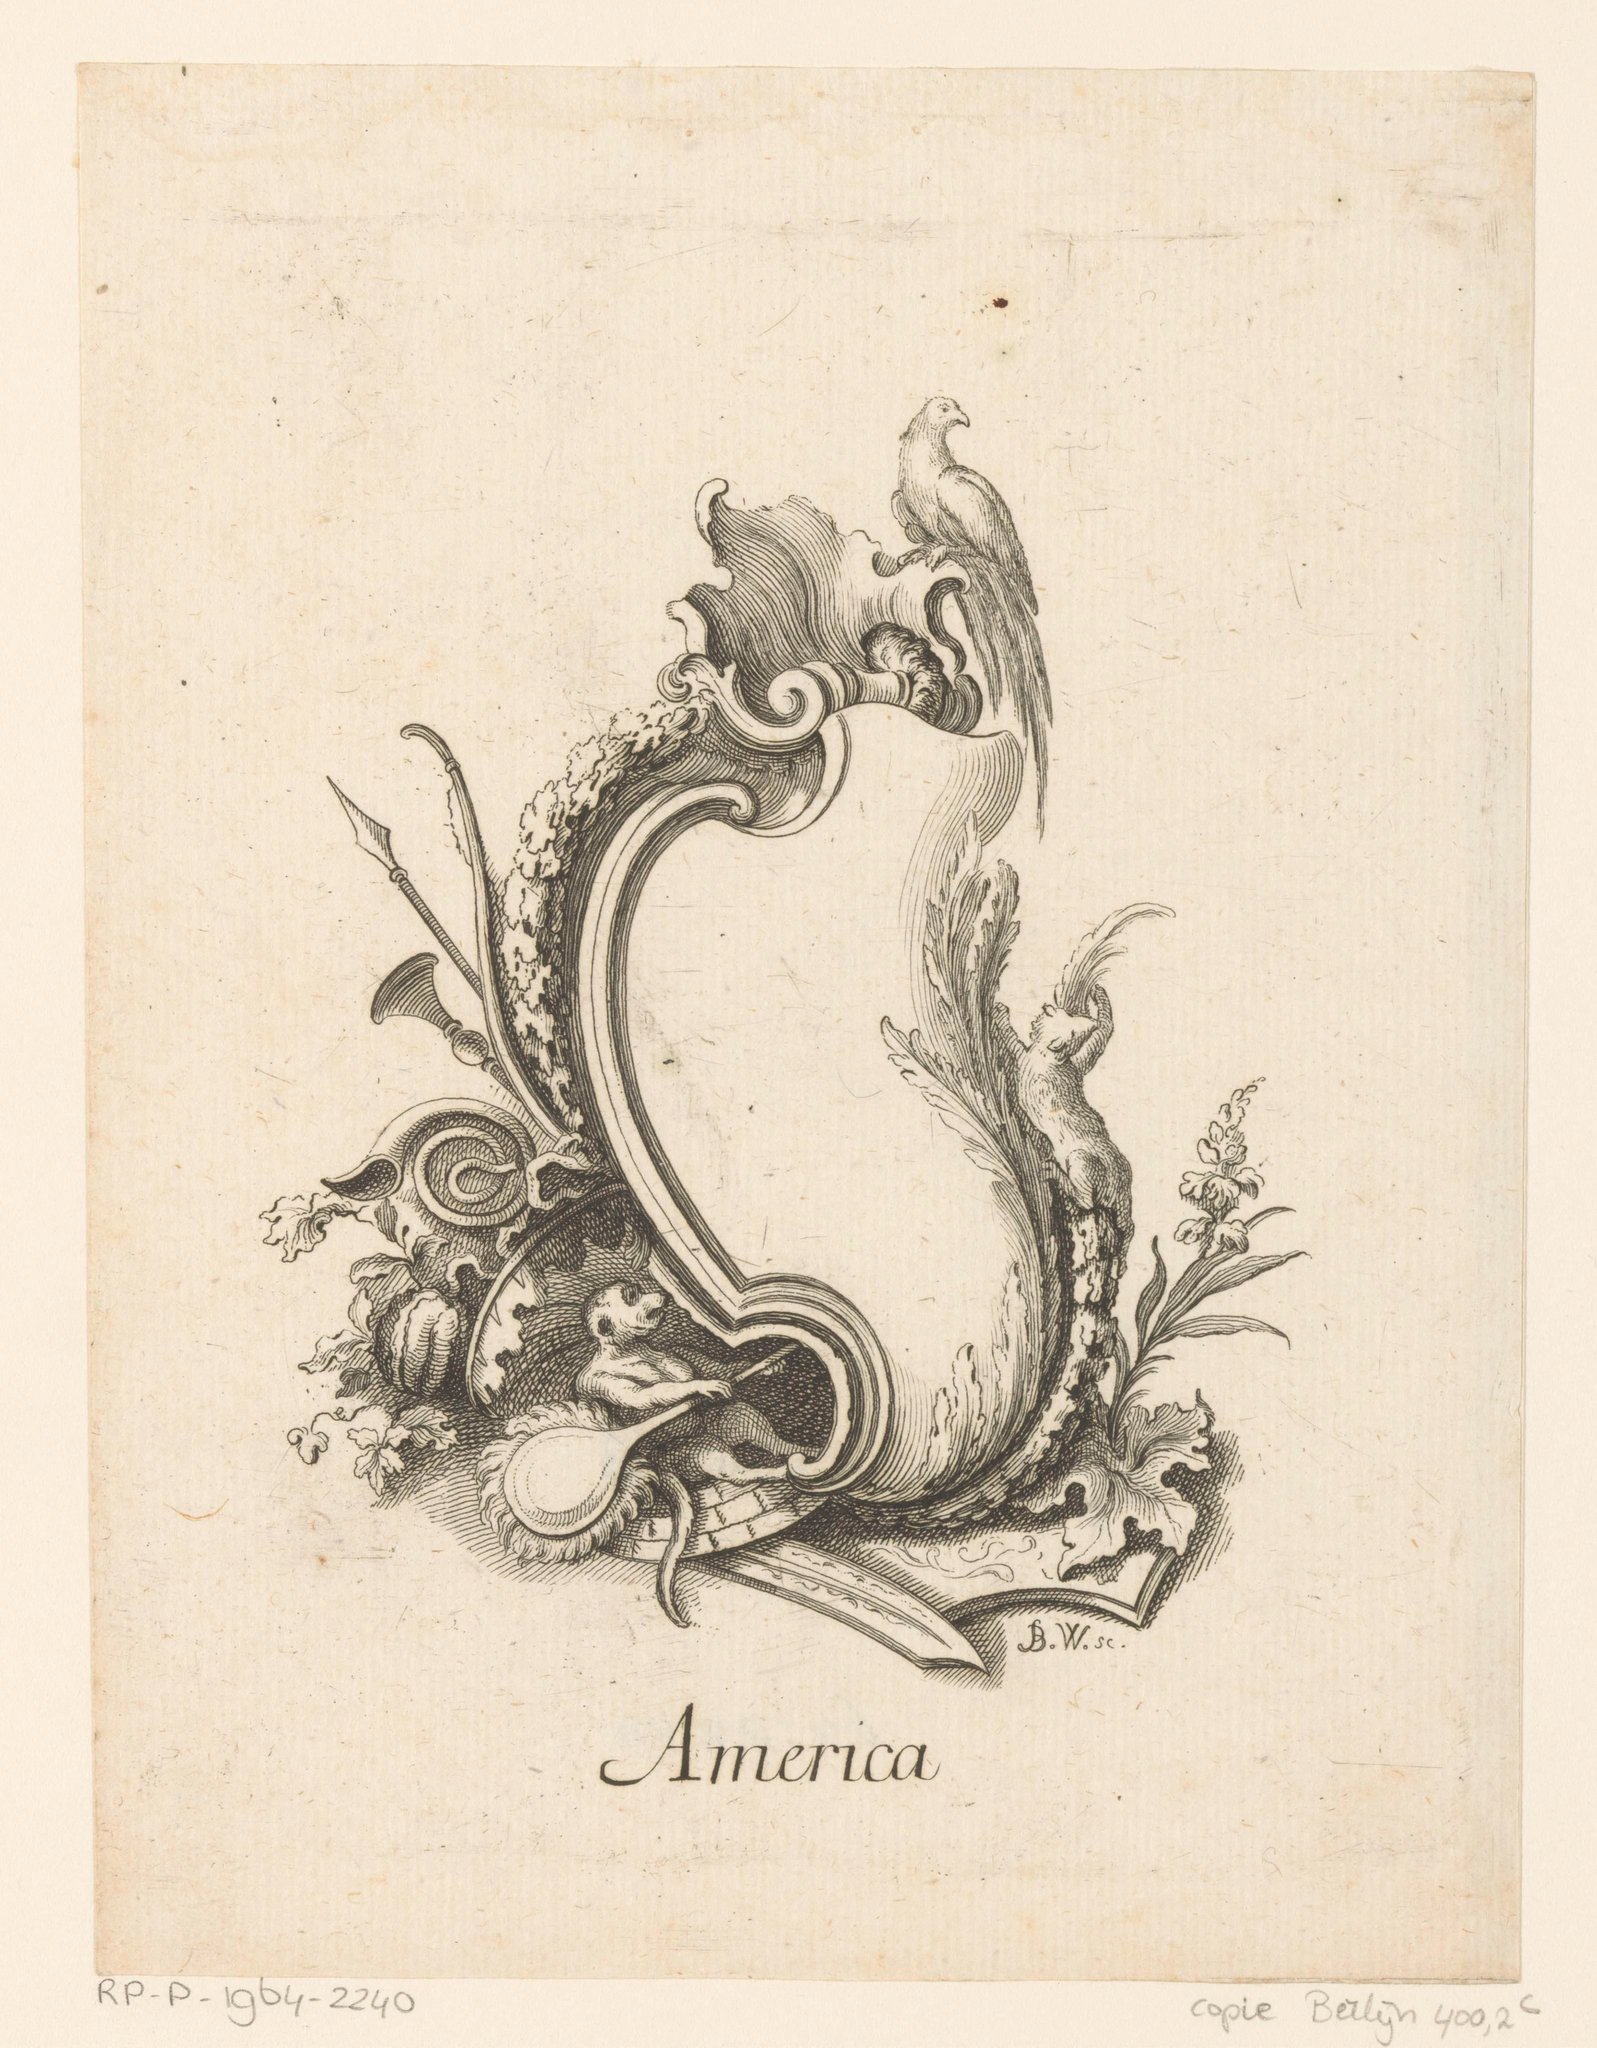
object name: ornament print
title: Neu Inventirte Schilde Erster Theil / Premier Livre de Cartouches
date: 1750-1770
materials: paper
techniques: etching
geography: augsburg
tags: america represented allegorically; 'america' (ripa), ornament ~ cartouche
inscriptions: collector's mark: Lugt 2228, collector's mark: Lugt 2760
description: Een cartouche omgeven door wapens en dieren zoals een aap met een waaier en een vogel.